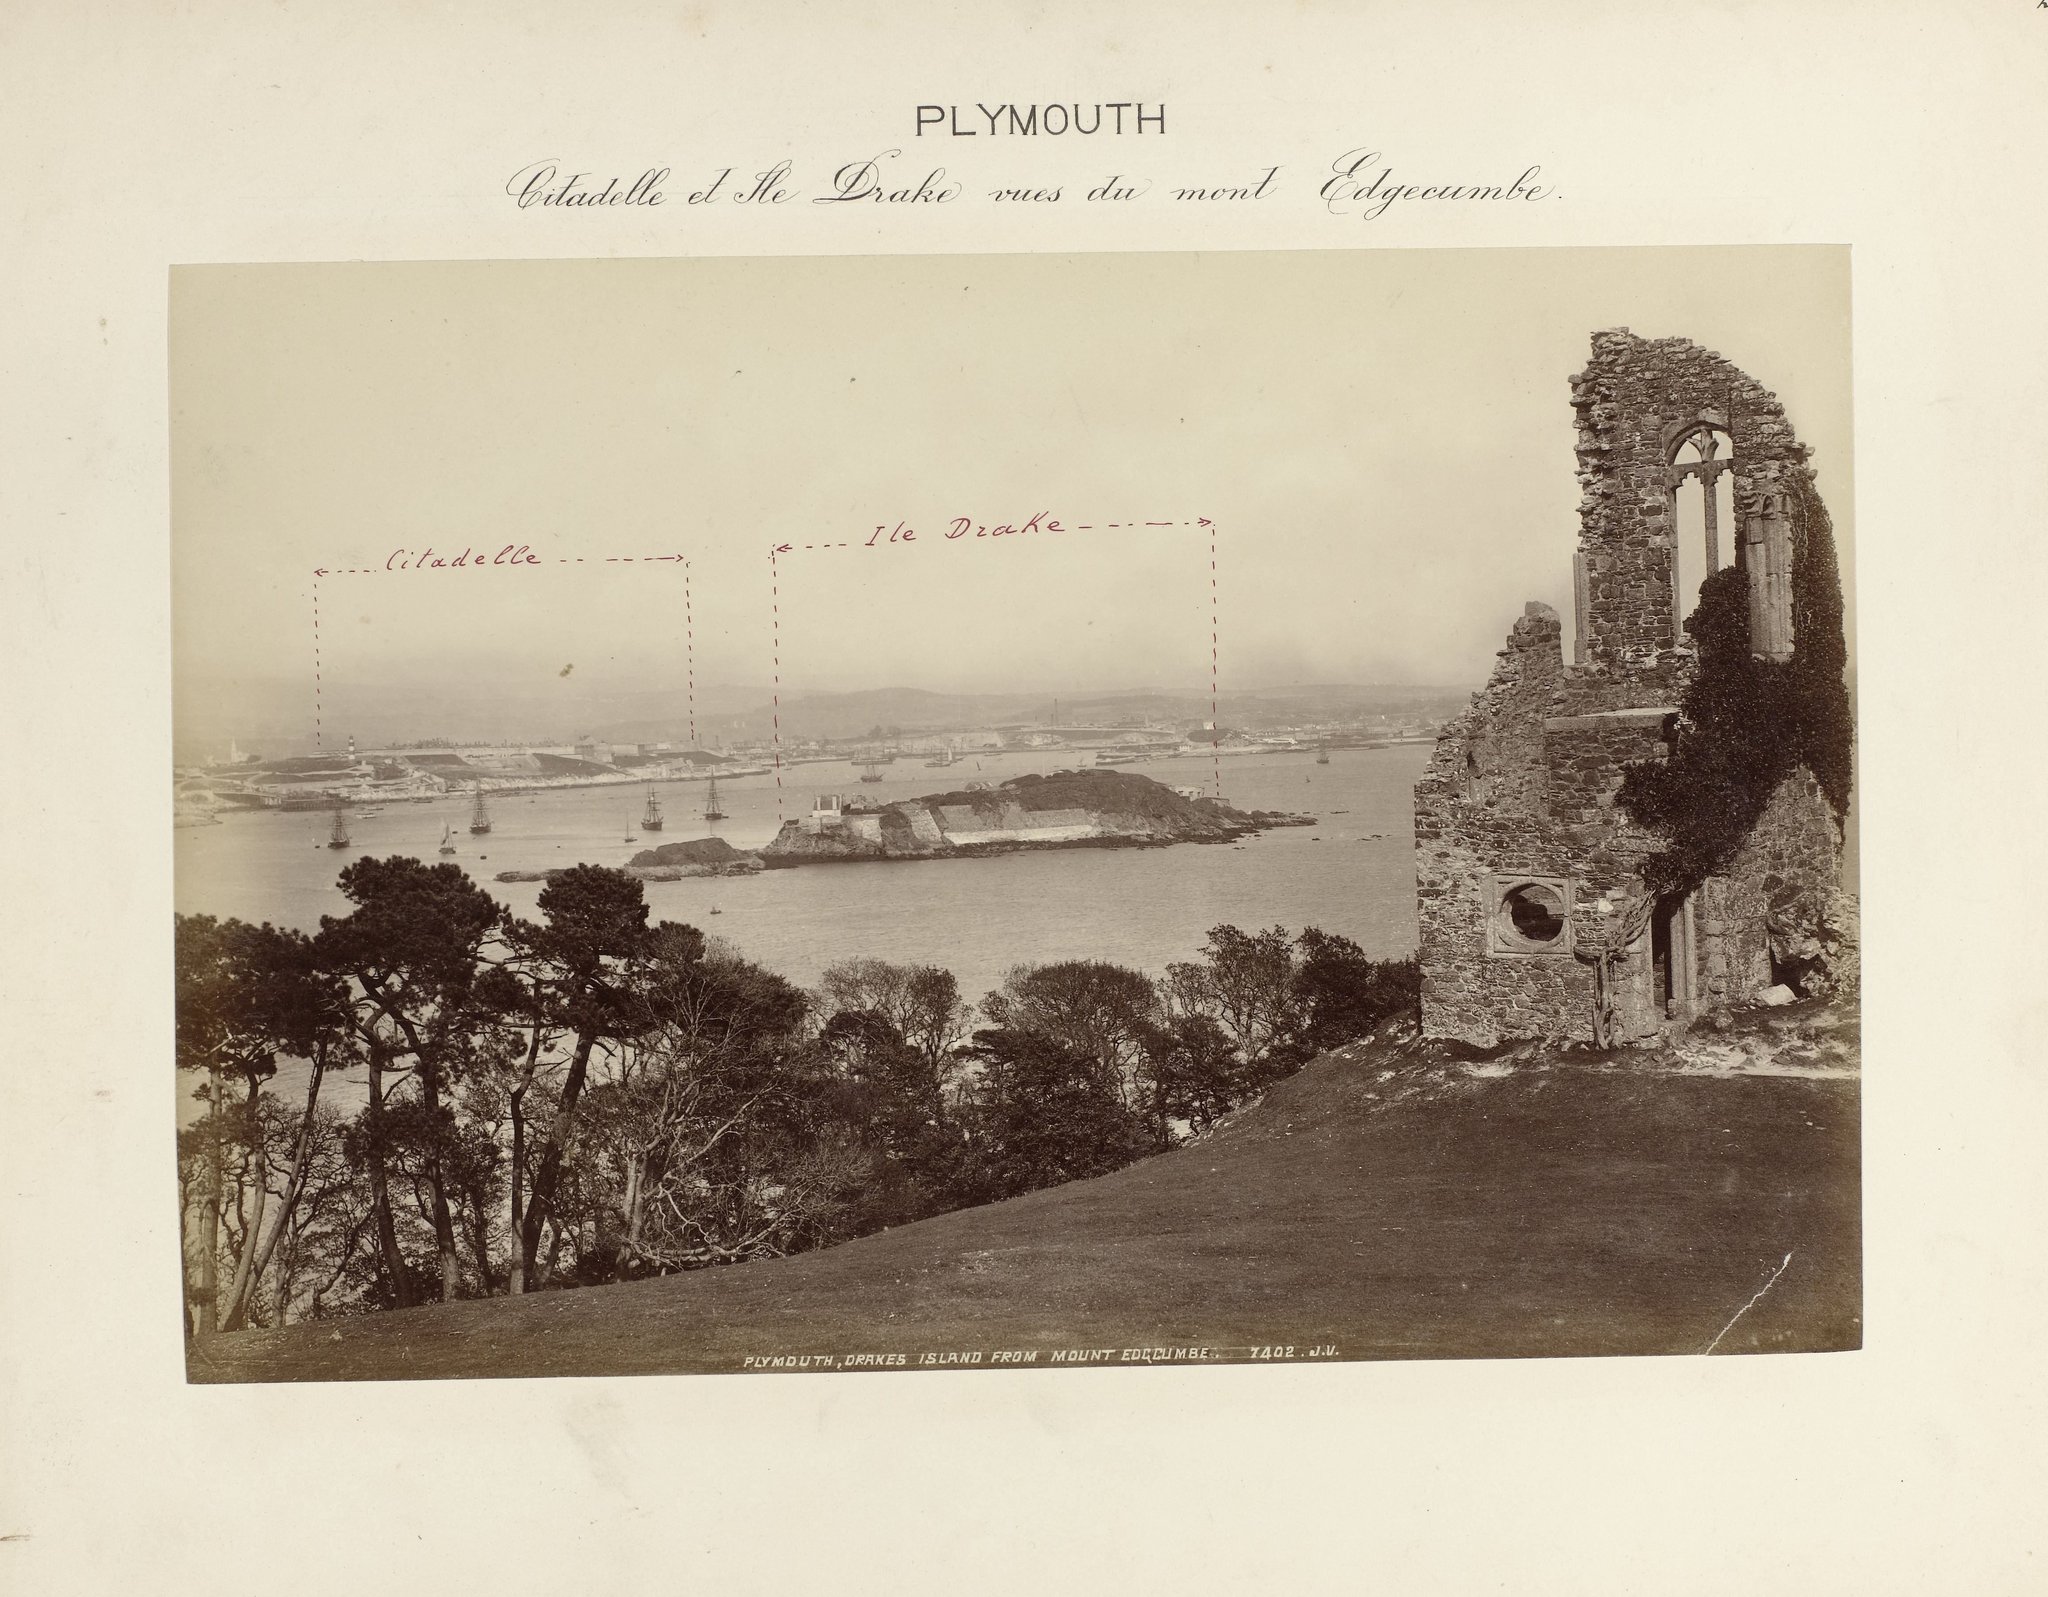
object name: photograph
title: Angleterre. Défense des côtes. Reconaissance de 1891. Photographies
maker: james valentine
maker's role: fotograaf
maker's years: 1815-1880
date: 1891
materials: cardboard, paper, photographic support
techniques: albumen print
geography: great britain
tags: plymouth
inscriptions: annotation: ‘citadelle // Ile Drake’, inscription: ‘PLYMOUTH / Citadelle et Ile Drake vues du mont Edgecumbe.’, inscription: ‘PLYMOUTH, DRAKES ISLAND FROM MOUNT EDGCUMBE. 7402 J.V.’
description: Foto uit een album met 35 topografische foto's van Britse kustplaatsen, waarop in pen militaire verdedigingswerken zijn aangegeven door een Franse militair.